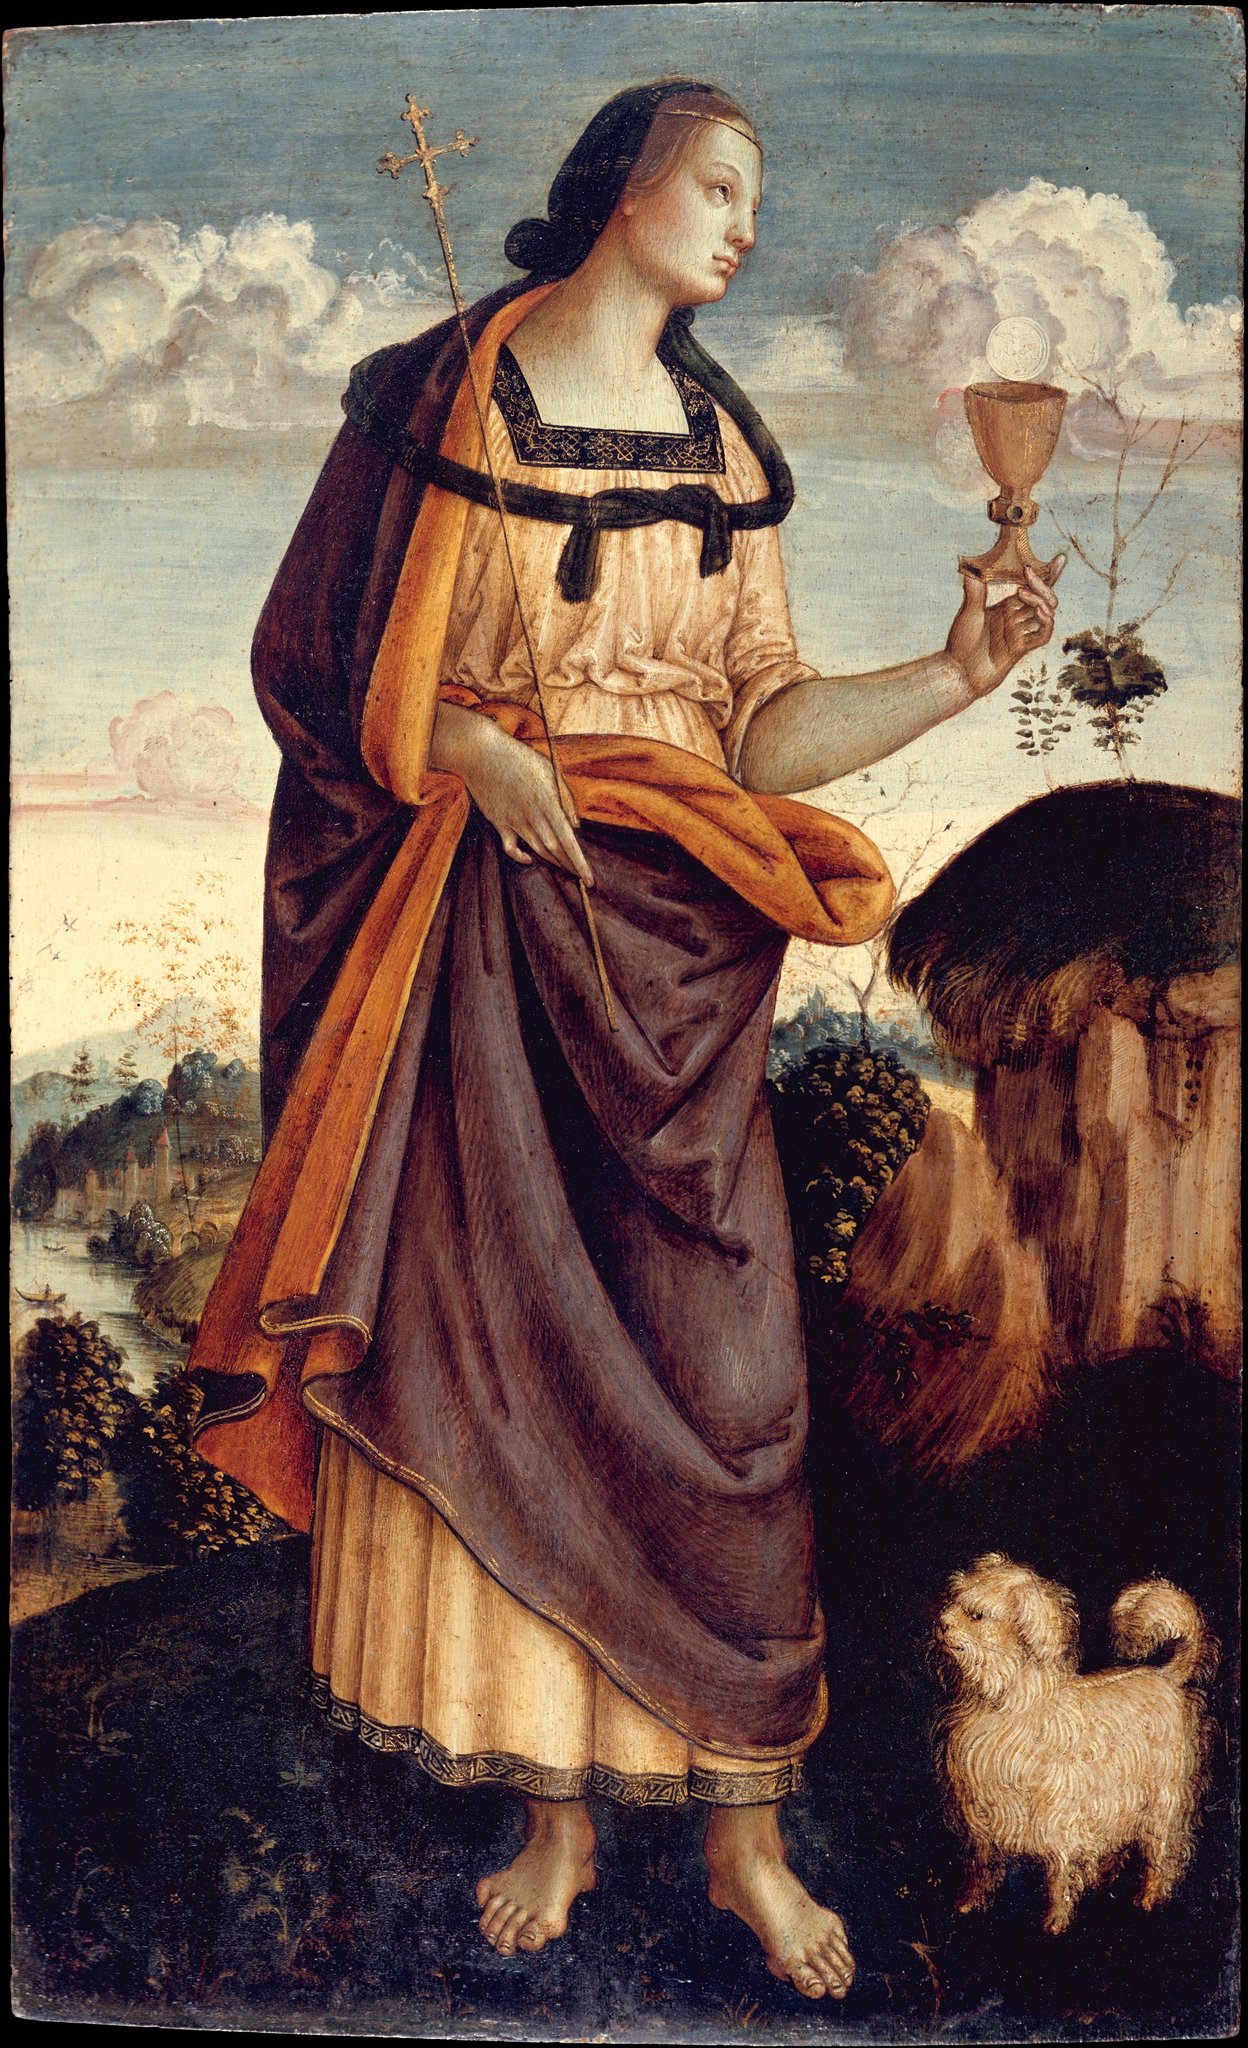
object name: painting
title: The Theological Virtues: Faith, Charity, Hope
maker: italian (umbrian) painter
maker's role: artist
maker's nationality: italian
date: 1495-1505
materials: gold, paint, wood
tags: infants,women,phoenix,dogs,chalices,allegory